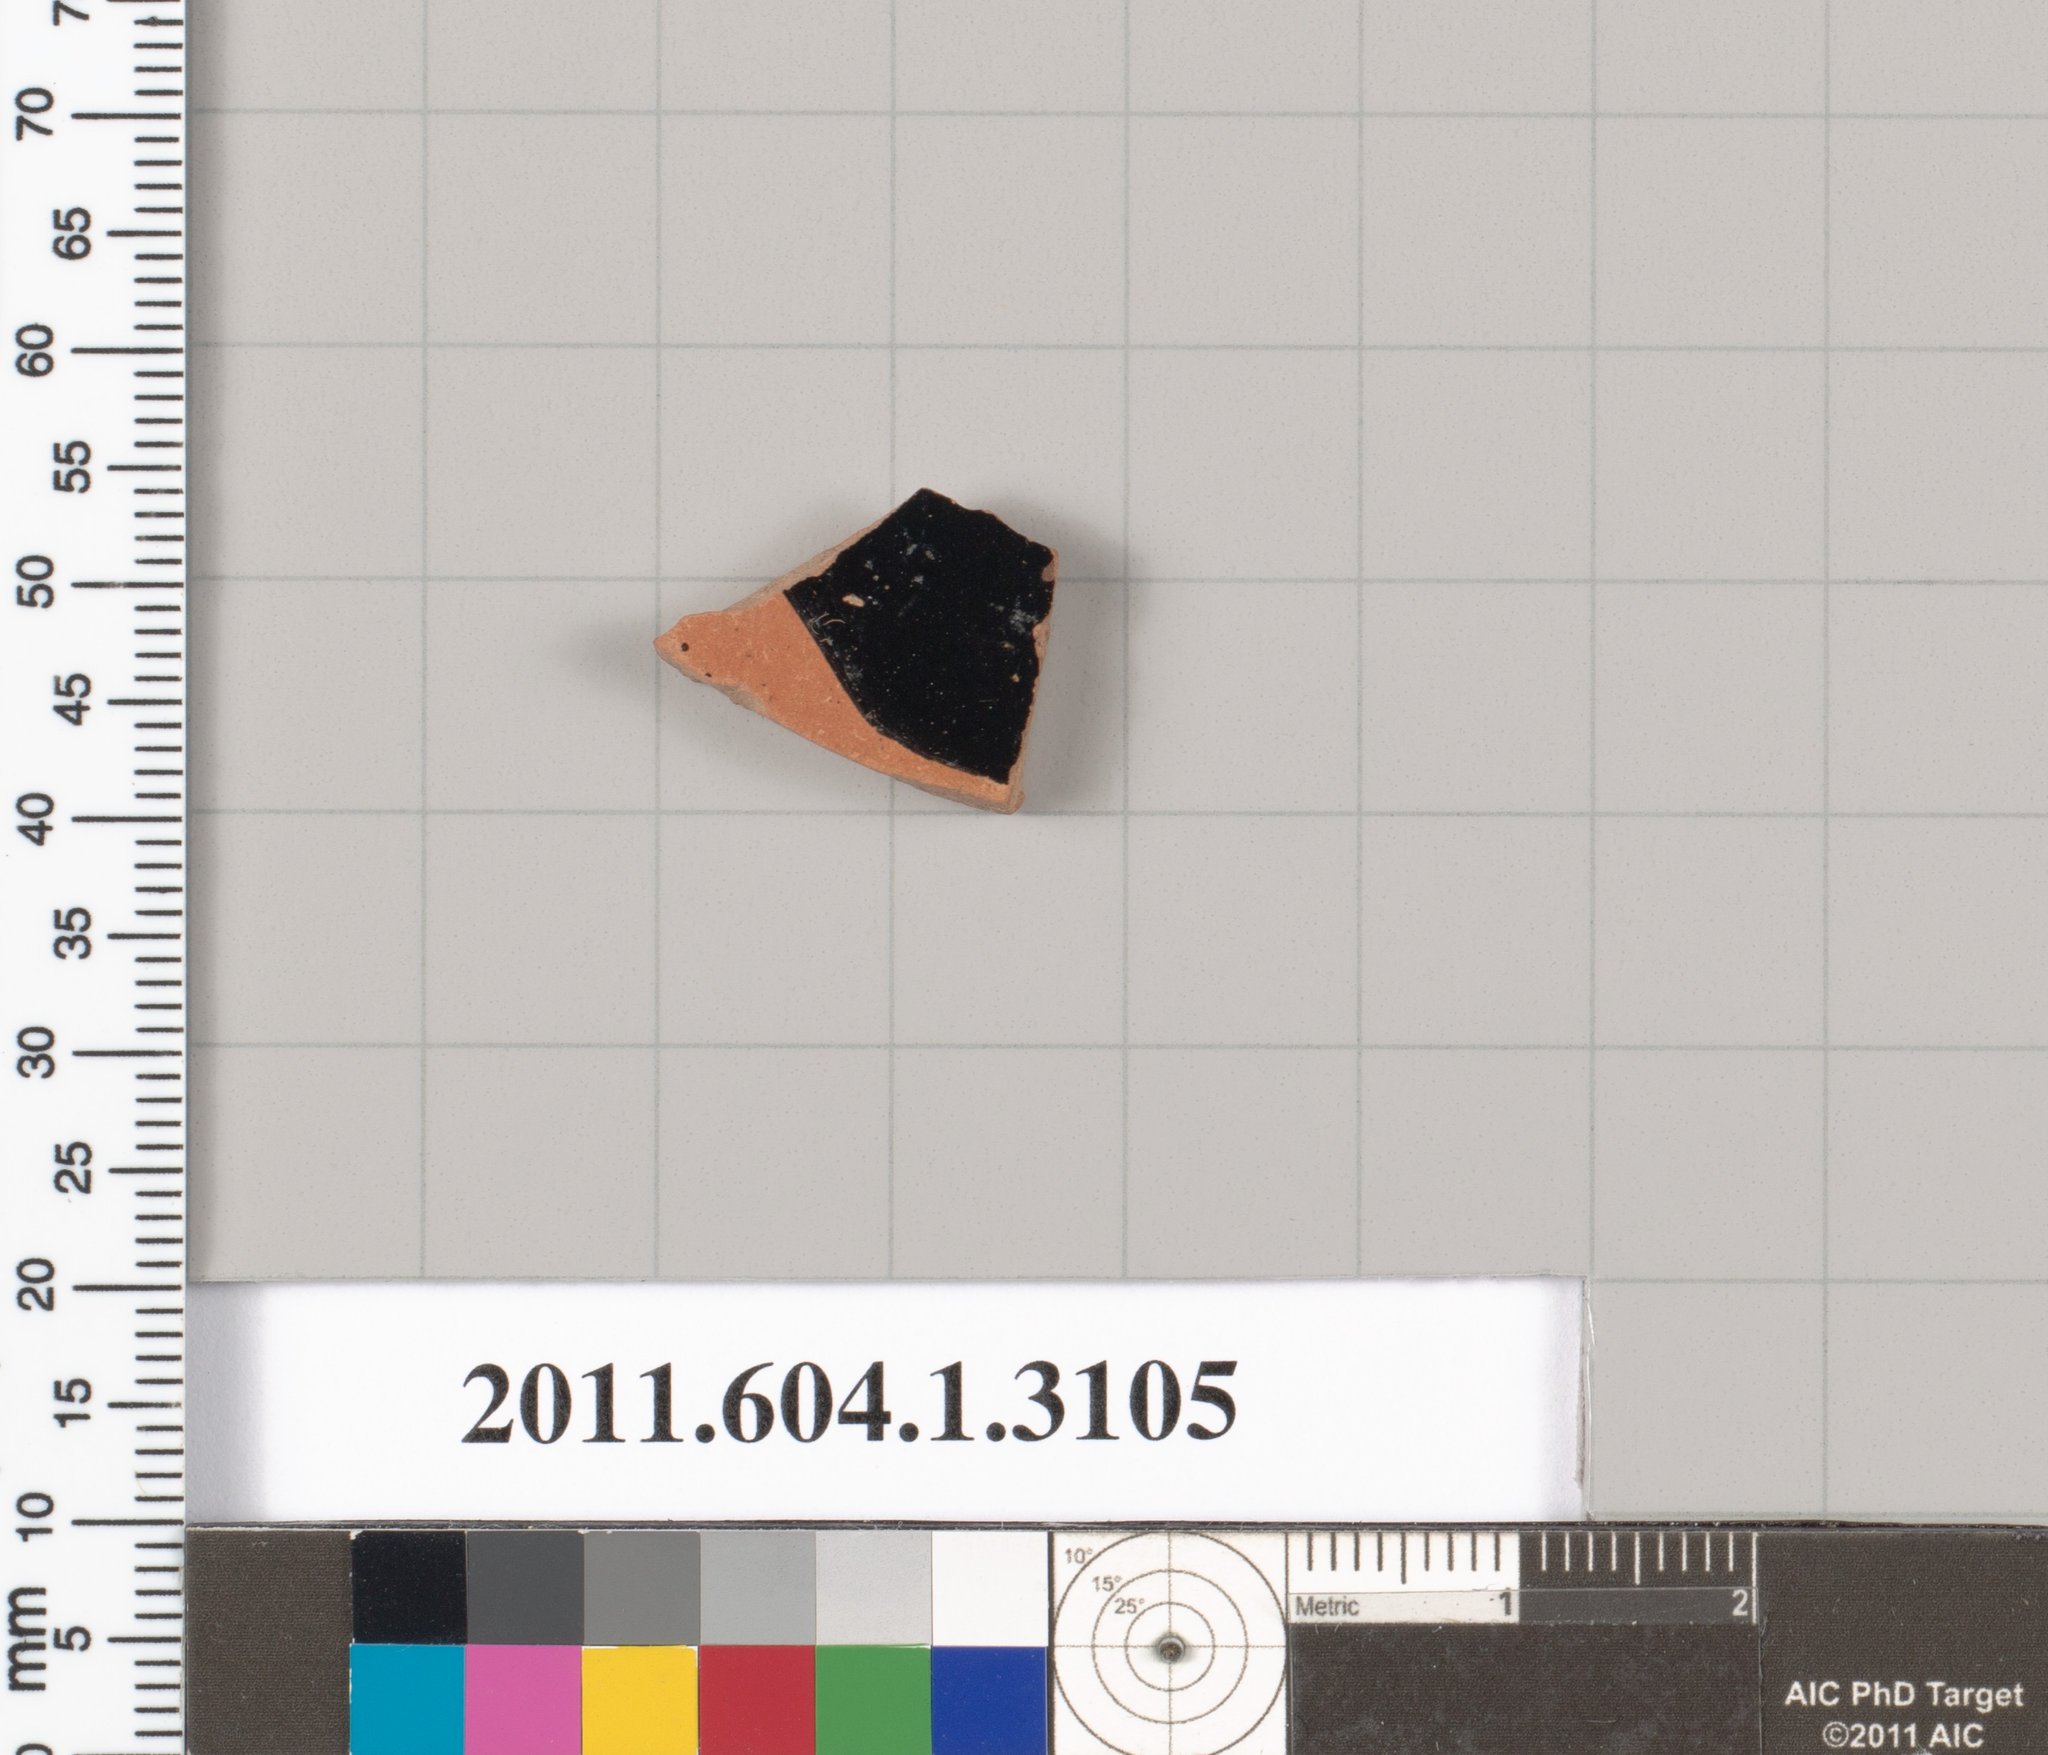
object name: kylix fragment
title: Terracotta fragment of a kylix (drinking cup)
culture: greek, attic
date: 500-480 BCE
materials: terracotta